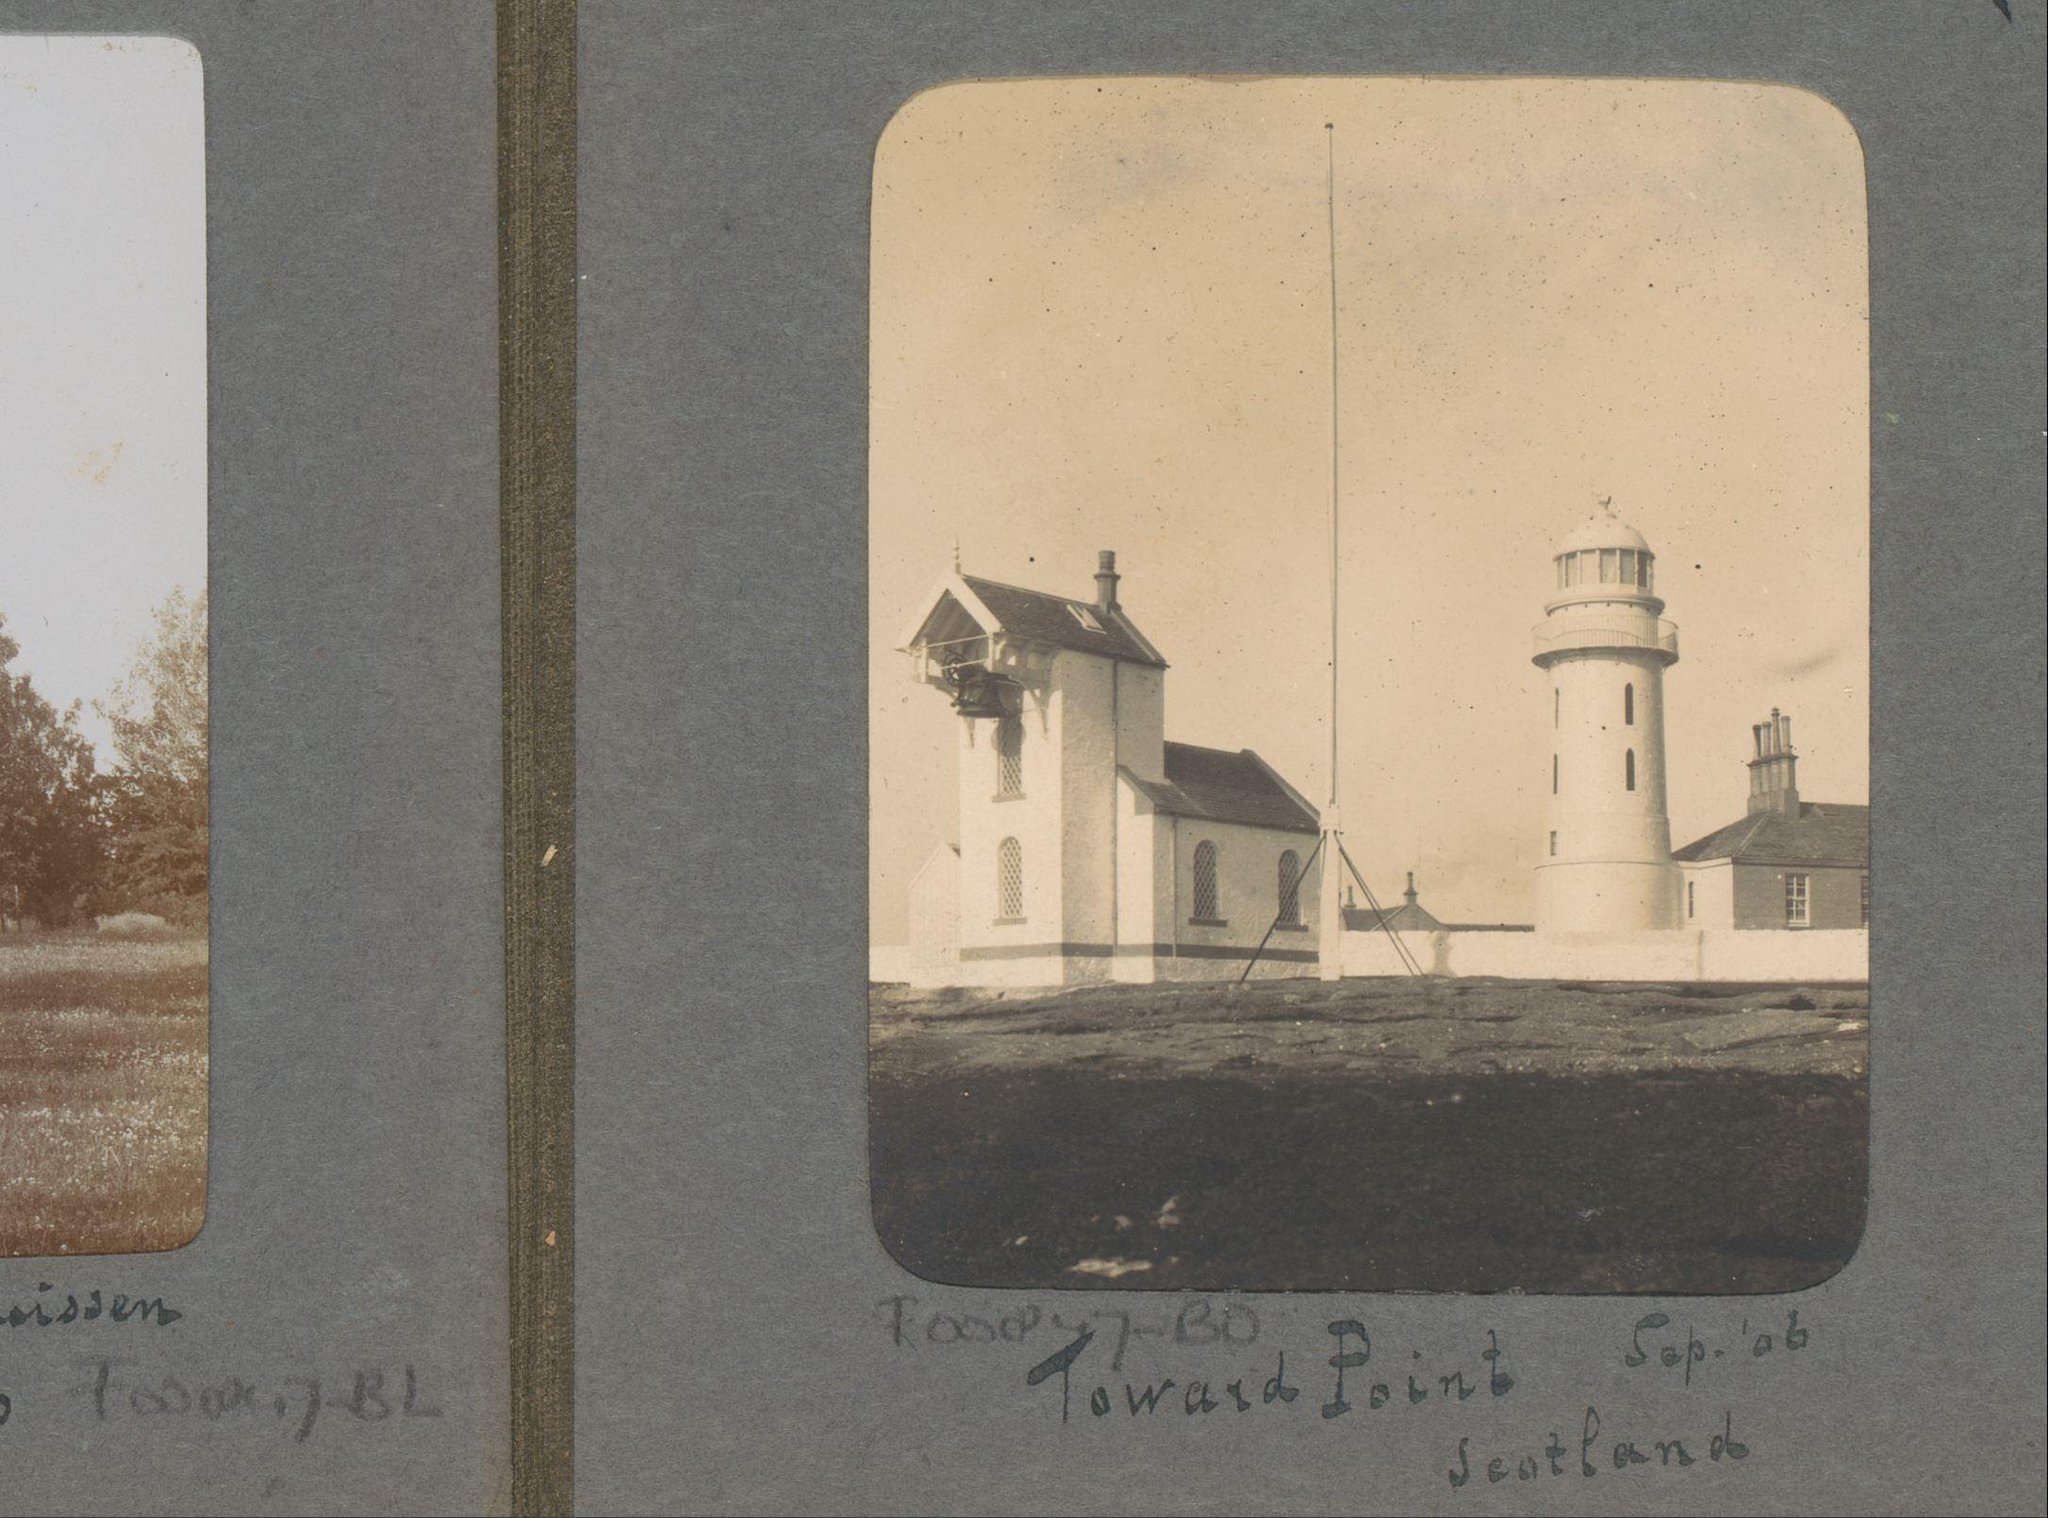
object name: photograph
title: Vuurtoren en het misthoorngebouw (Foghorn Building) van Toward Point in Schotland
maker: Anonymous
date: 1906-1909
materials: cardboard, paper, photographic support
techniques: gelatin silver print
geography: toward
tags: lighthouse, lightship, bell-buoy, whistling-buoy, other instruments ~ acoustic signalling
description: Onderdeel van Reisalbum van een Nederlandse familie met bezienswaardigheden in Europa, Egypte en New York.